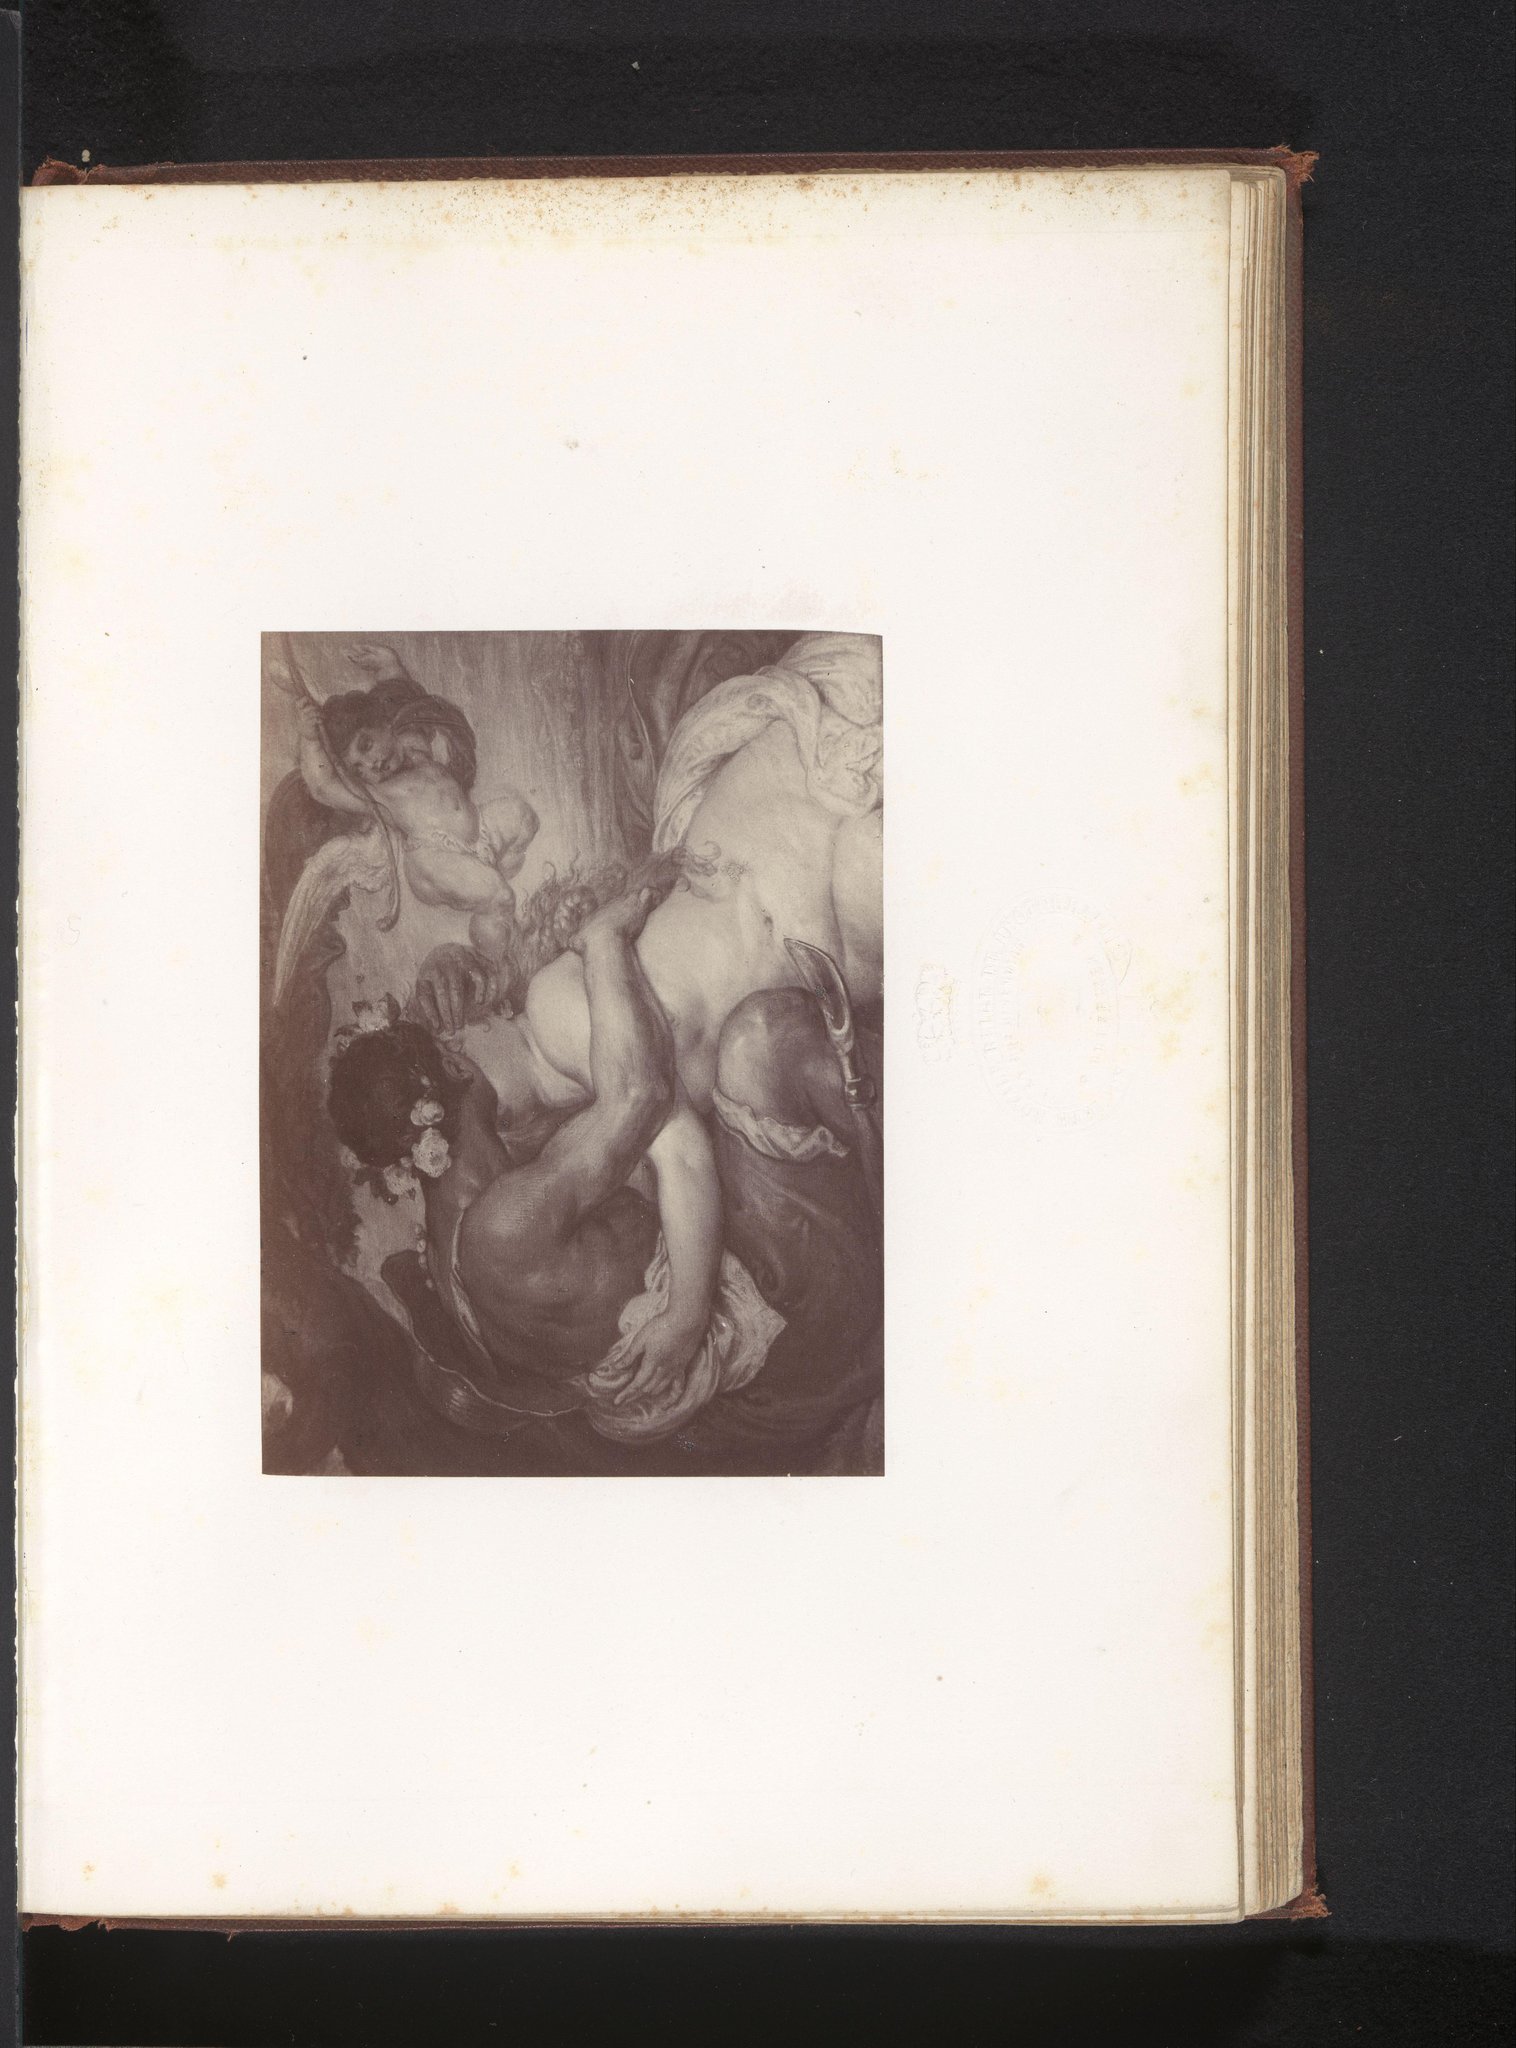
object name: page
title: Fotoreproductie van Filosofischer dan men denkt door Antoine Wiertz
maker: edmond fierlants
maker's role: fotograaf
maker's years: 1819-1869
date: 1863-1868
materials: photographic support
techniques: albumen print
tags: (lovers) kissing each other, cupids: 'amores', 'amoretti', 'putti'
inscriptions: check stamp: ‘SOCIÉTÉ ROYALE BELGE DE PHOTOGRAPHIE/ 69, RUE KEYENVELD/ BRUXELLES’